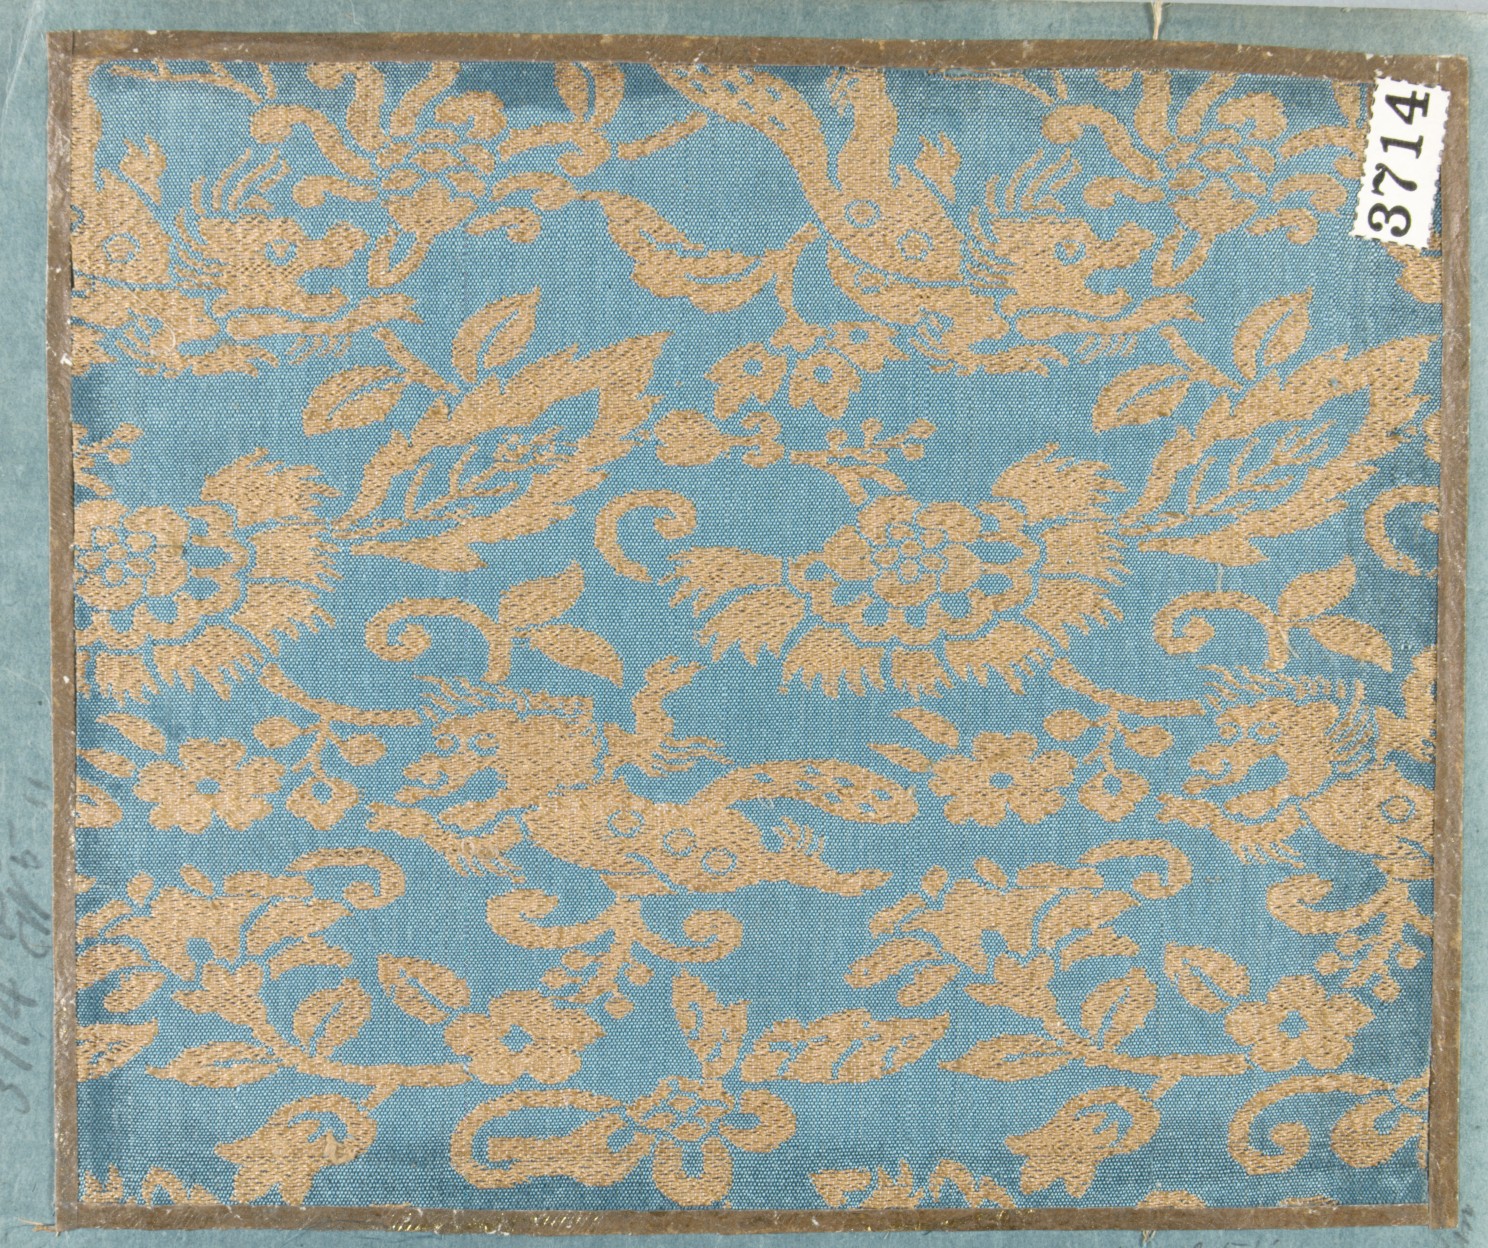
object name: sample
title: Textile Sample from Sample Book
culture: japanese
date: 1801-1900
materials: silk